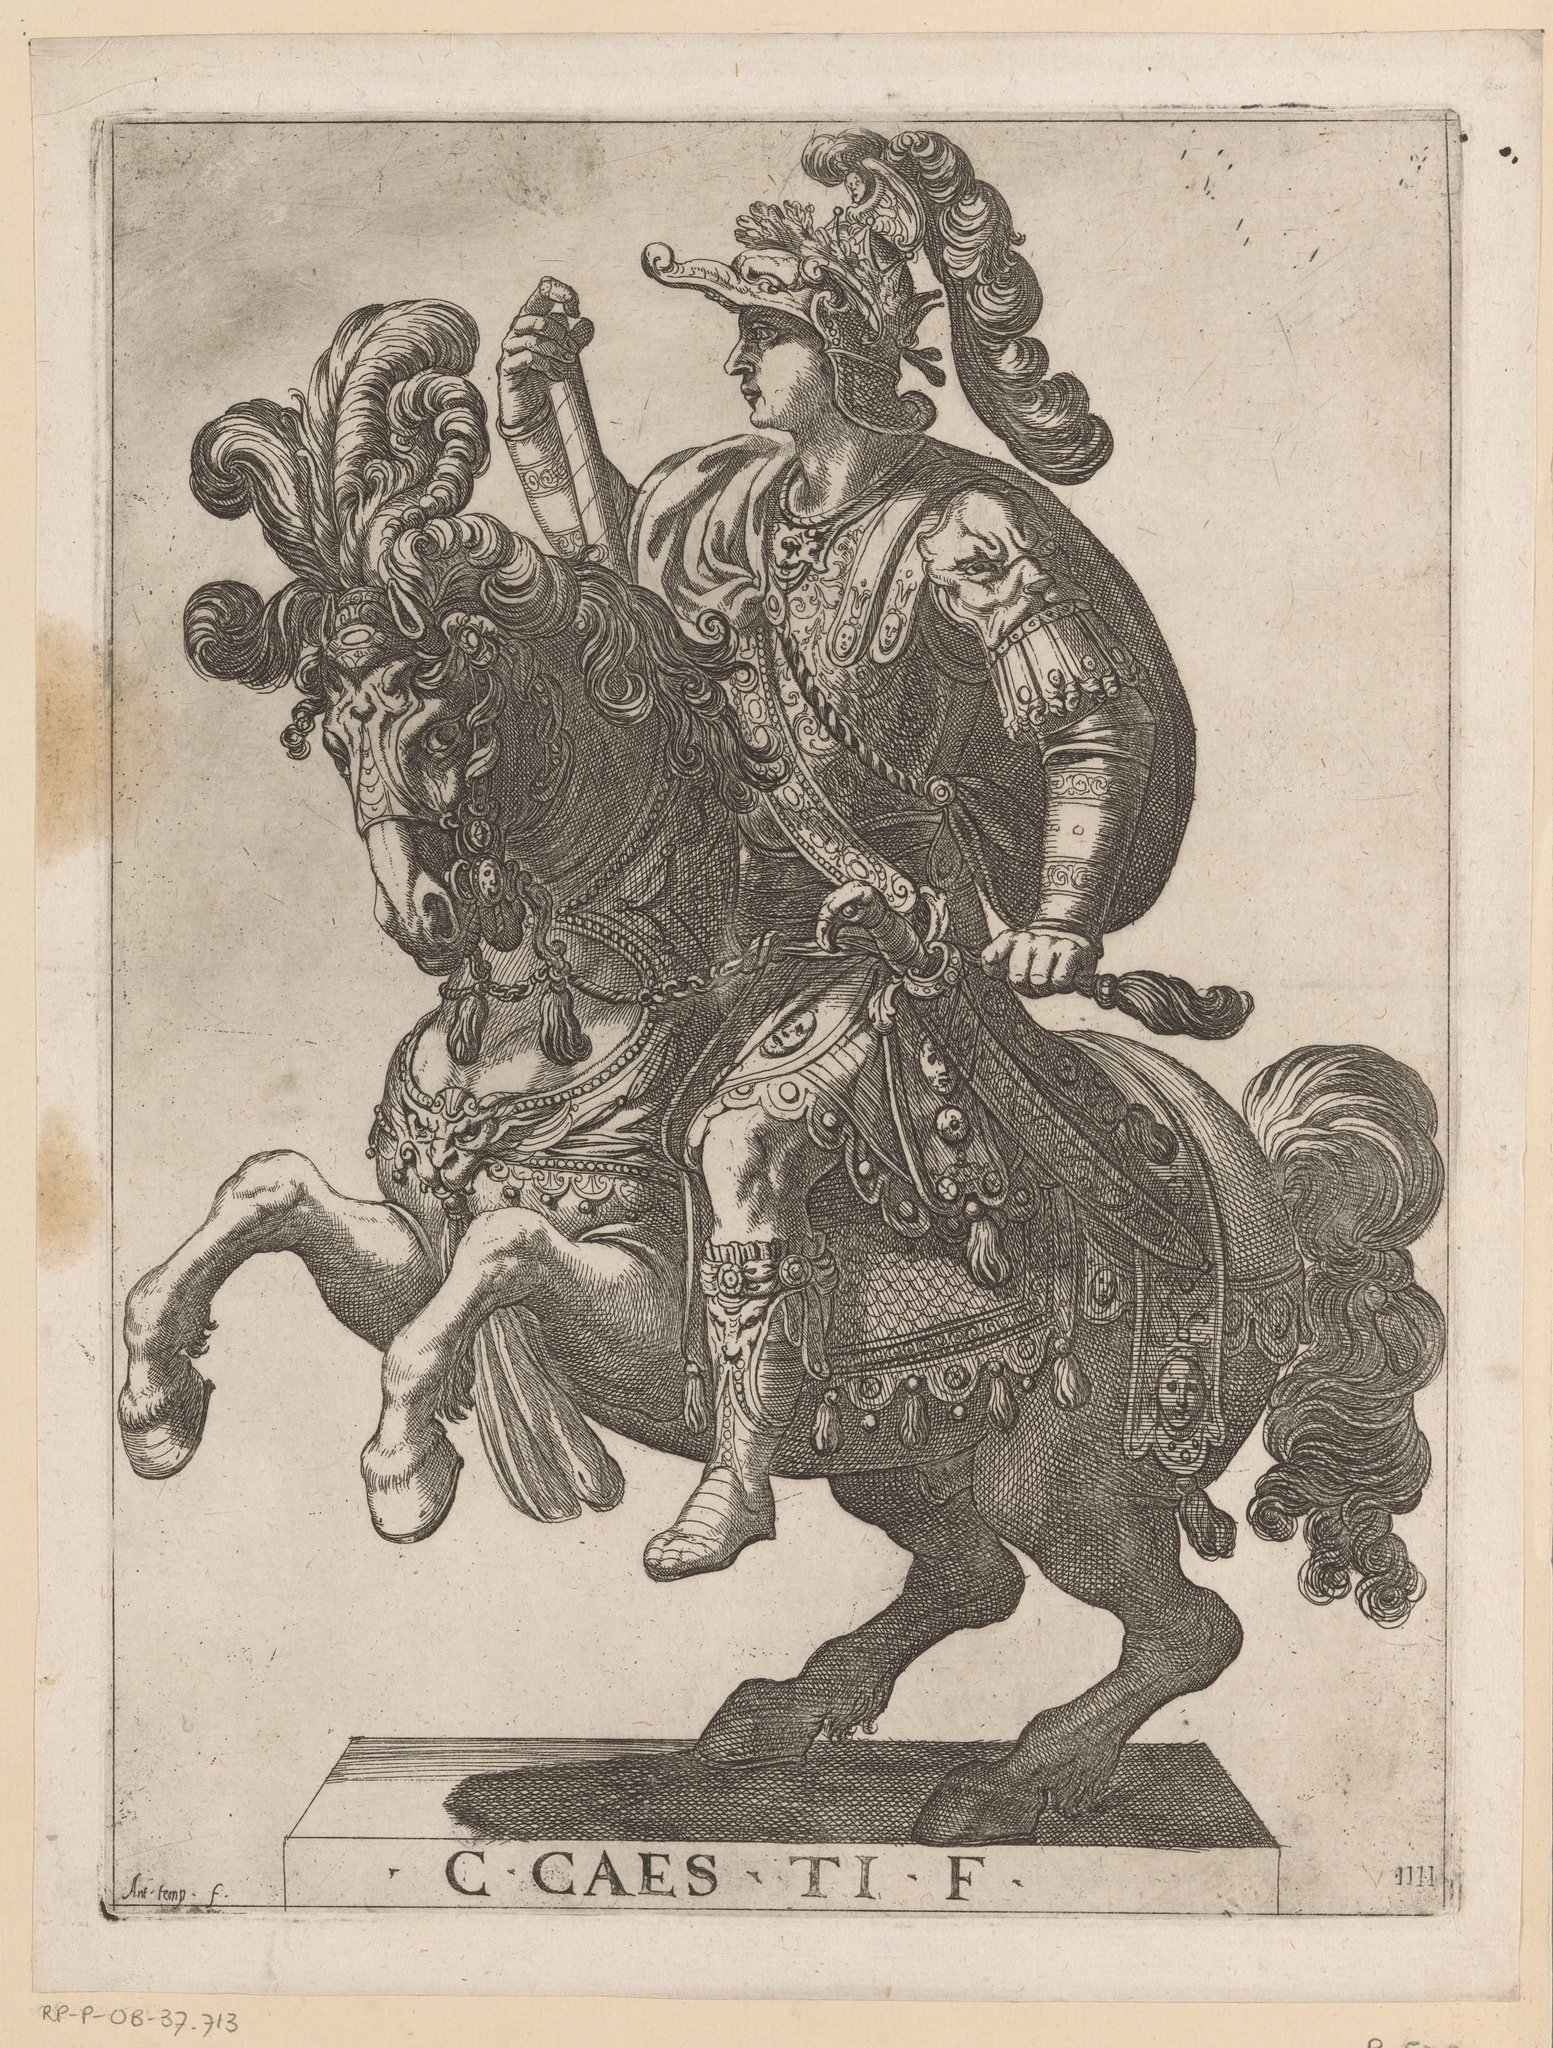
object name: print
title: Keizer Gaius te paard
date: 1596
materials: paper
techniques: etching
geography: italy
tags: germany, rome, 98b(caligula, gaius)9 male persons from classical history (caligula, gaius) - portrait of person from classical history, emperor, equestrian statue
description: Titelprent bij een reeks van twaalf prenten van Romeinse keizers.